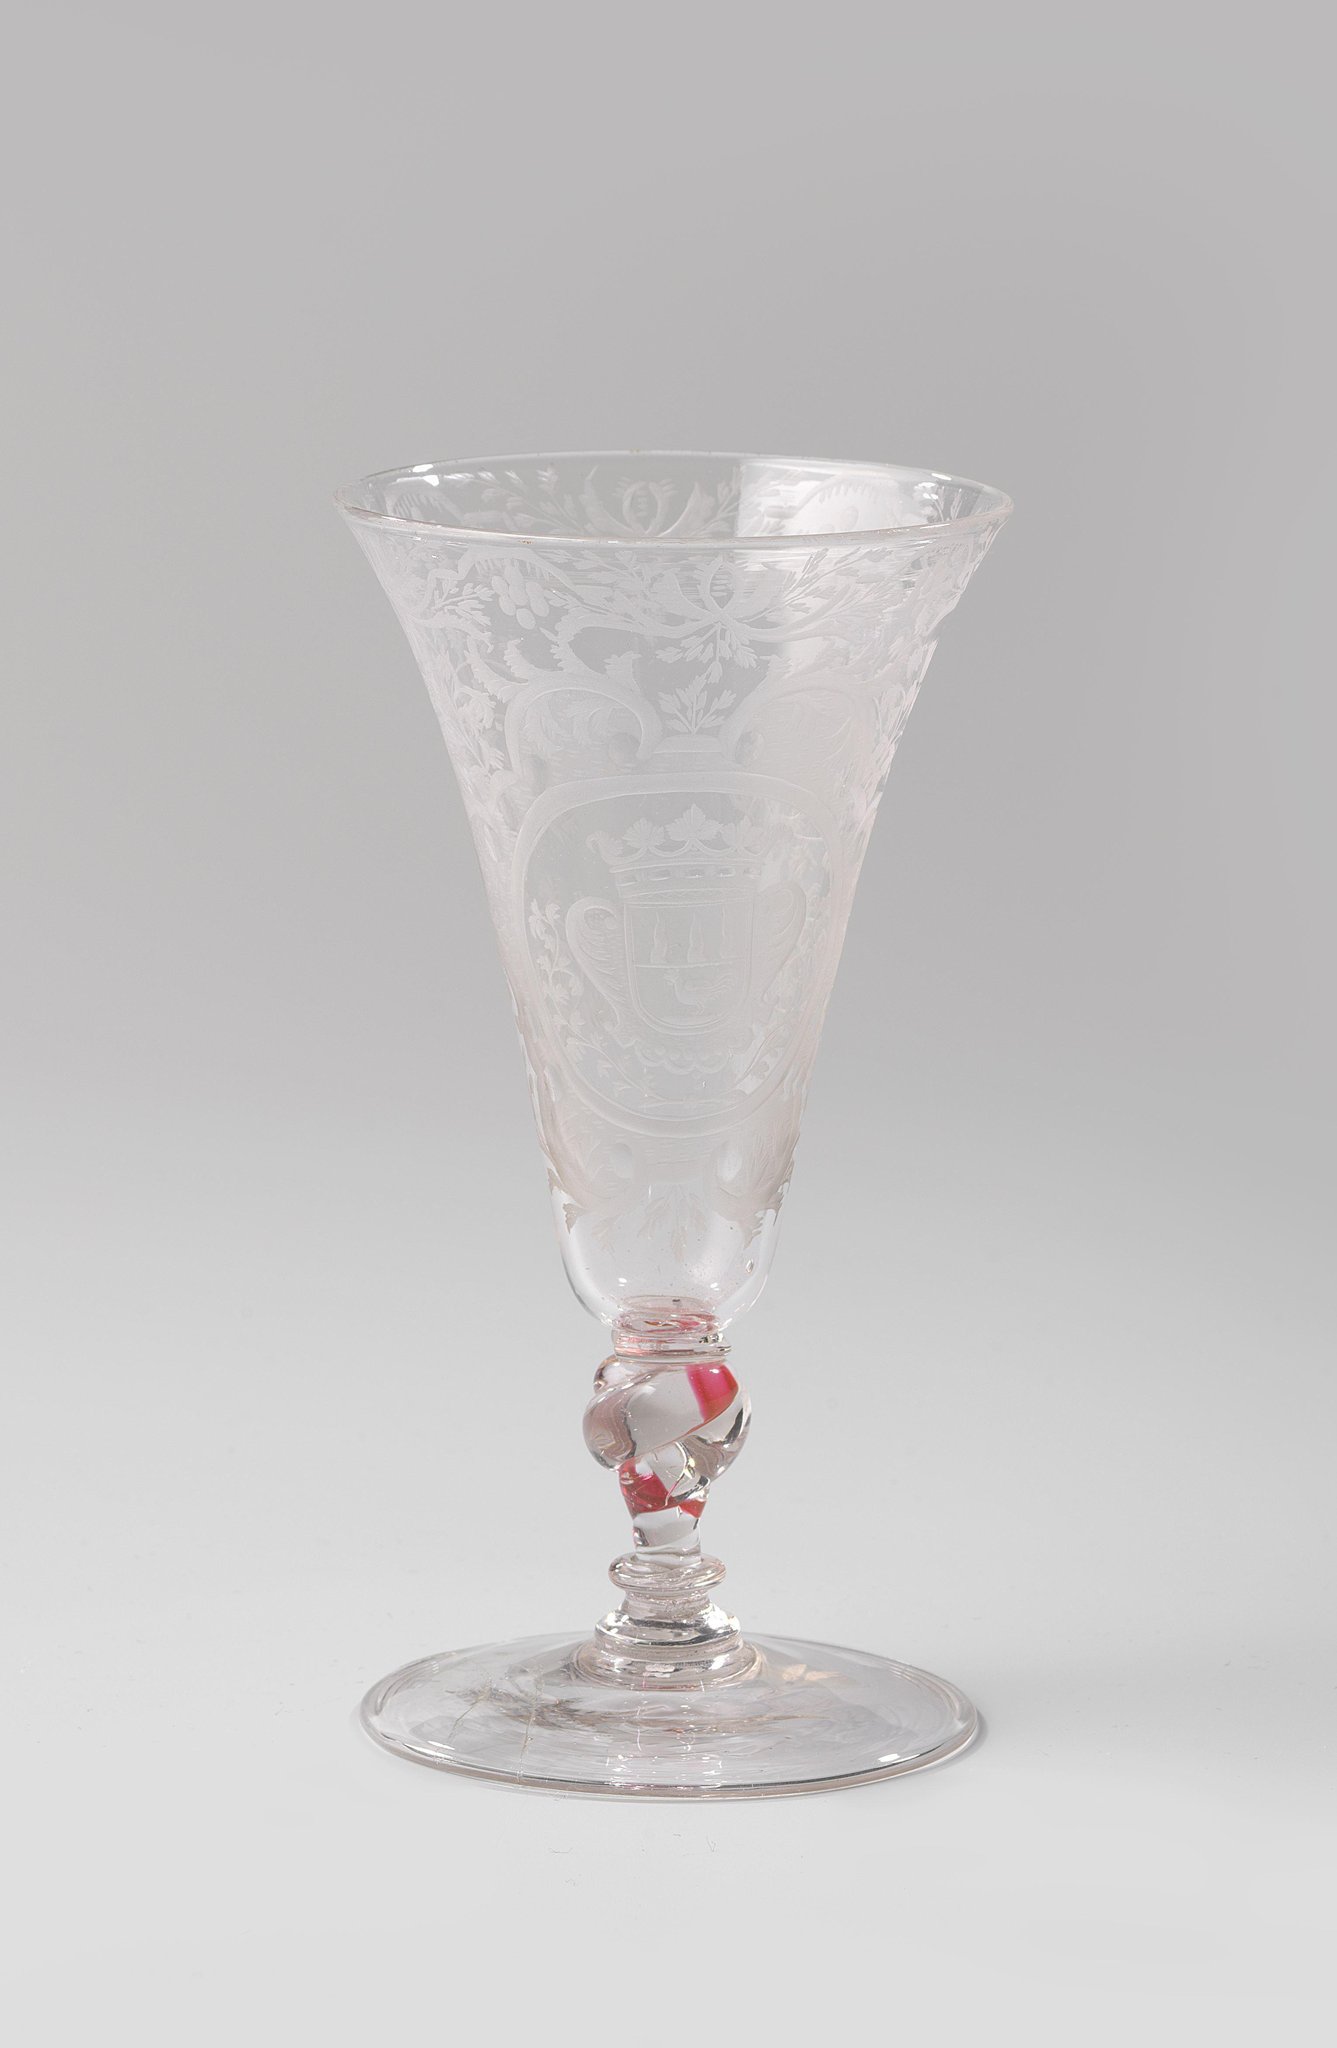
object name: wine goblet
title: Wijnglas met het wapen van de familie Van Beuningen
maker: Anonymous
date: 1700-1725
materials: glass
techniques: rotary engraving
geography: dresden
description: Wijnglas van helder, kleurloos glas. Platte voet. De gedraaide, balustervormige stam heeft een rode spiraal, een luchtbel en drie mereses. De trechtervormige kelk heeft een afgeronde bodem. Op de kelk, in een cartouche bestaande uit voluten met gematteerde vlakken met stippen en cirkeltjes, omgeven door bladwerk, bevindt zich een ovaal medaillon met het gekroonde familiewapen Van Beuningen, geflankeerd door twee takken die aan de onderzijde aan elkaar gebonden zijn. Langs de mondrand een band met symmetrisch bladwerk en bloemtakken.